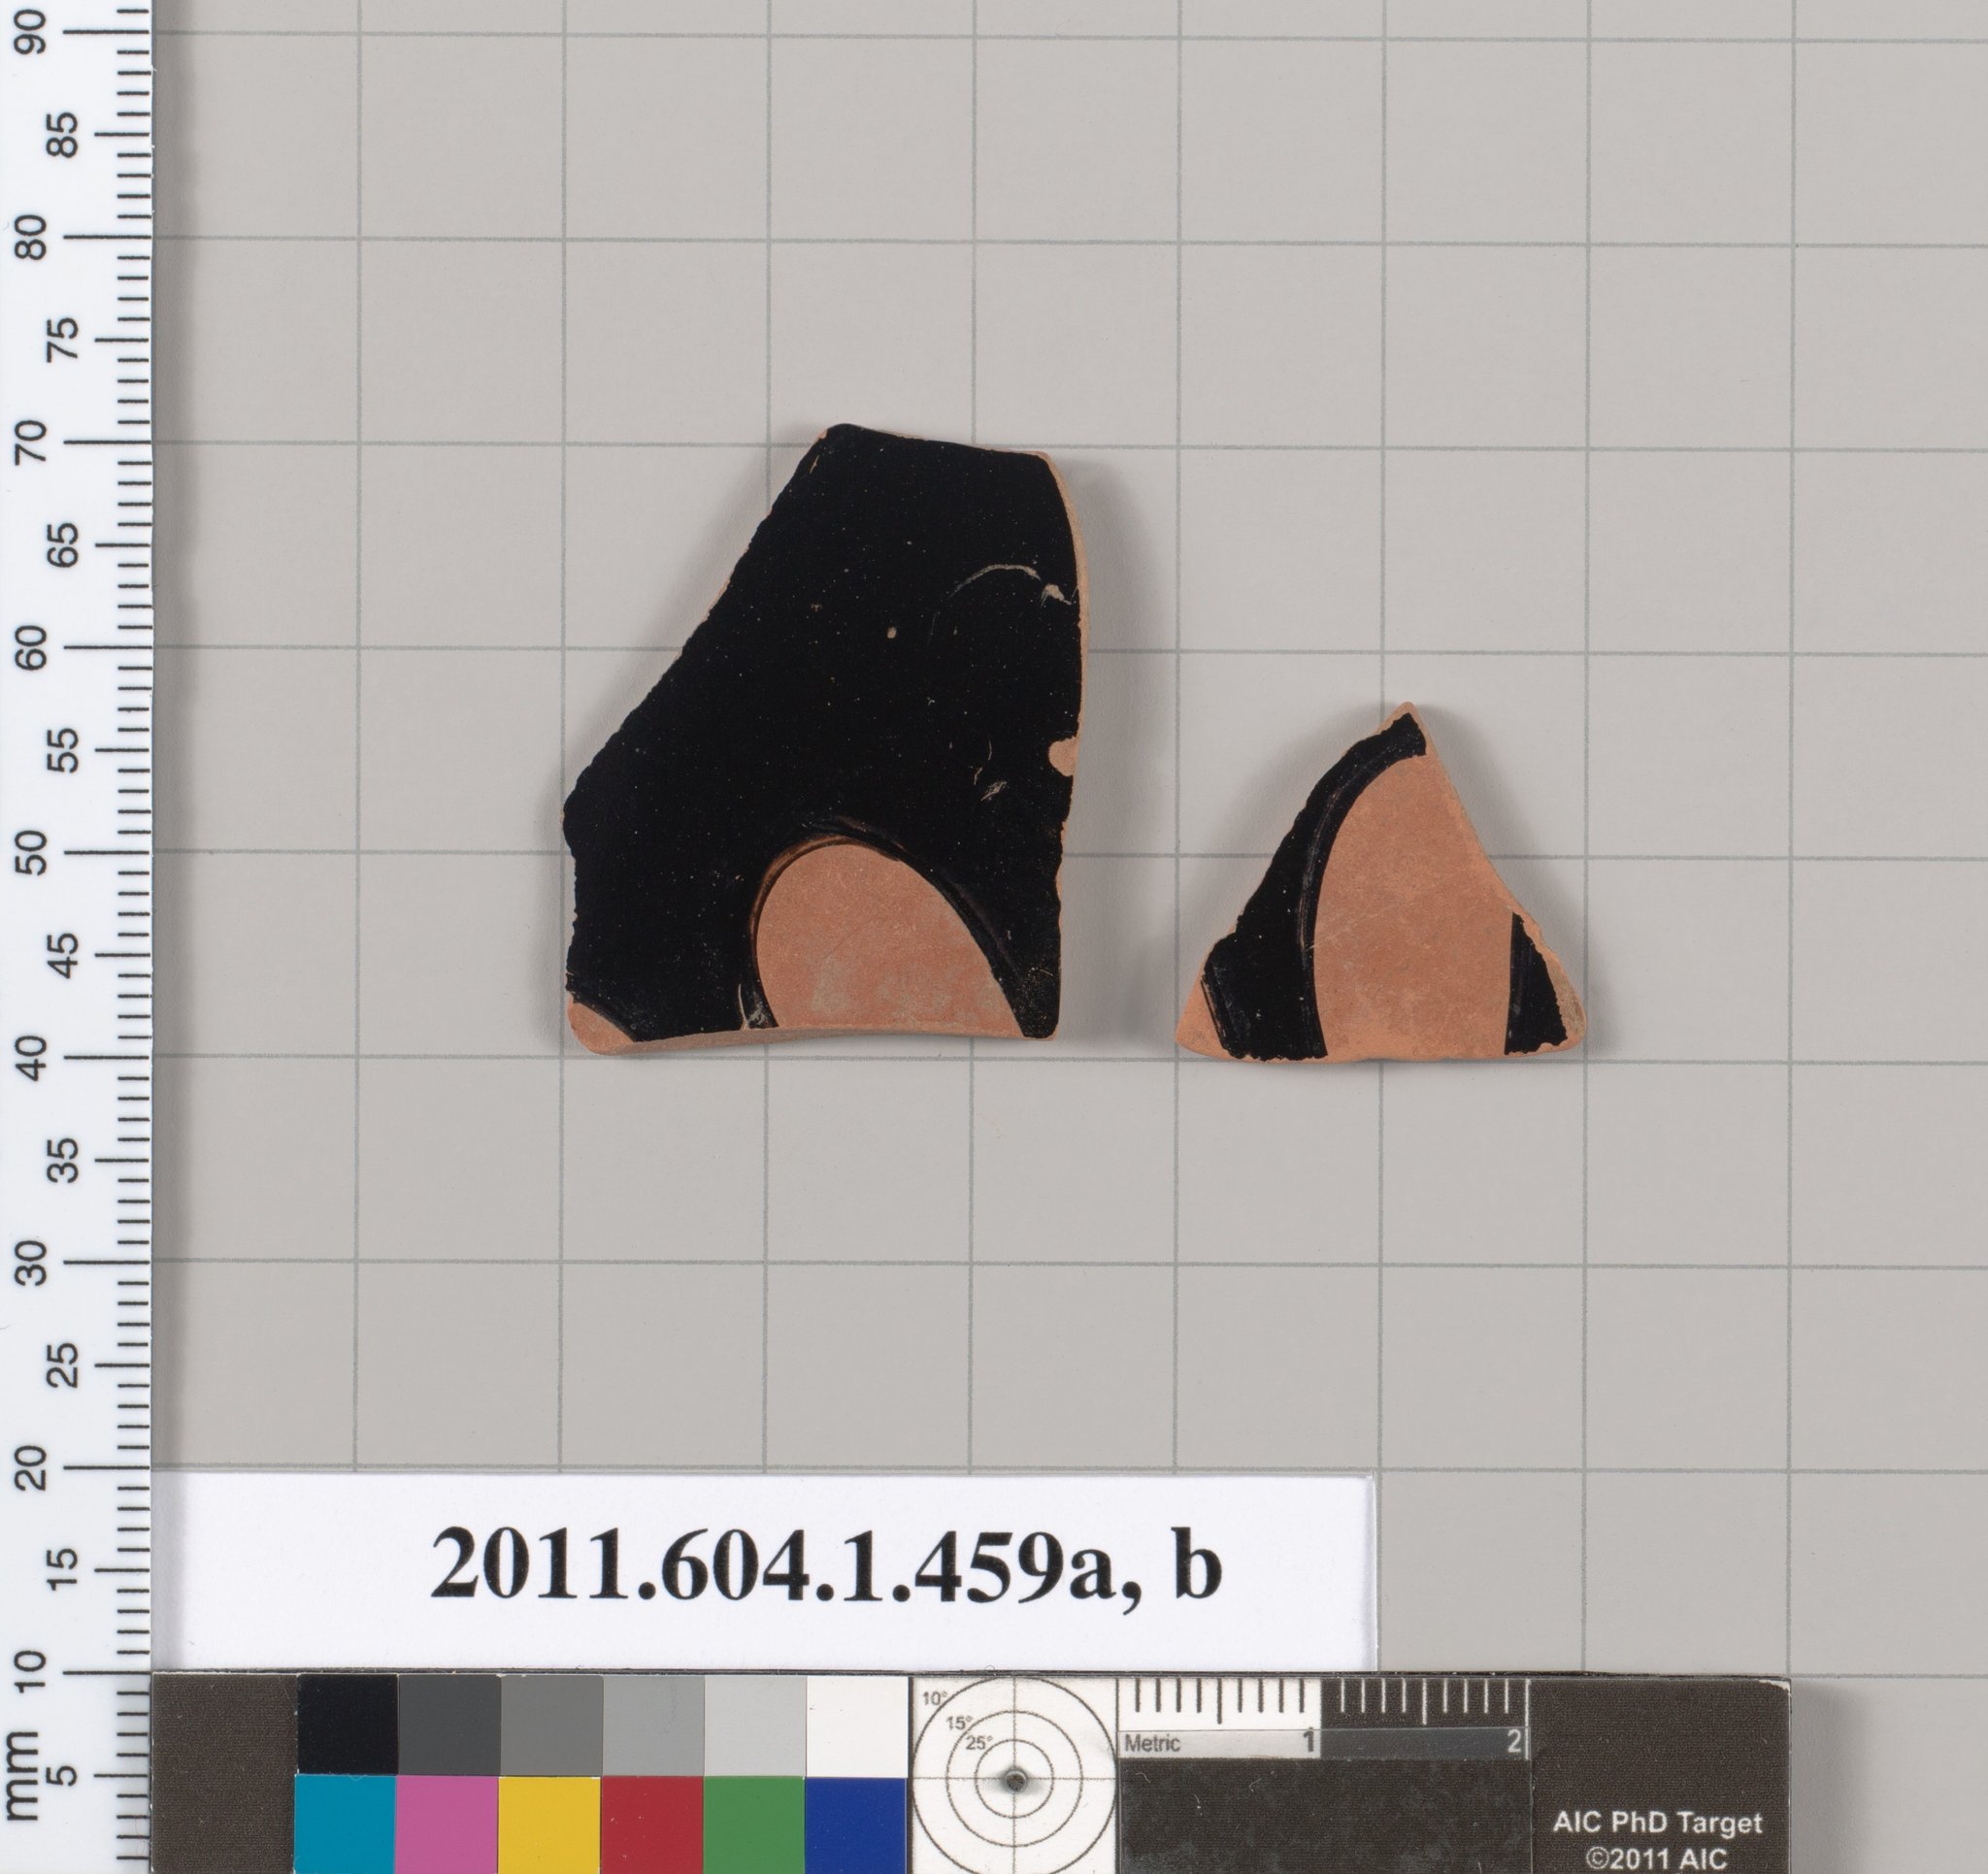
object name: kylix fragment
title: Terracotta fragments of kylikes (drinking cups)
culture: greek, attic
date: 520-500 BCE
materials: terracotta